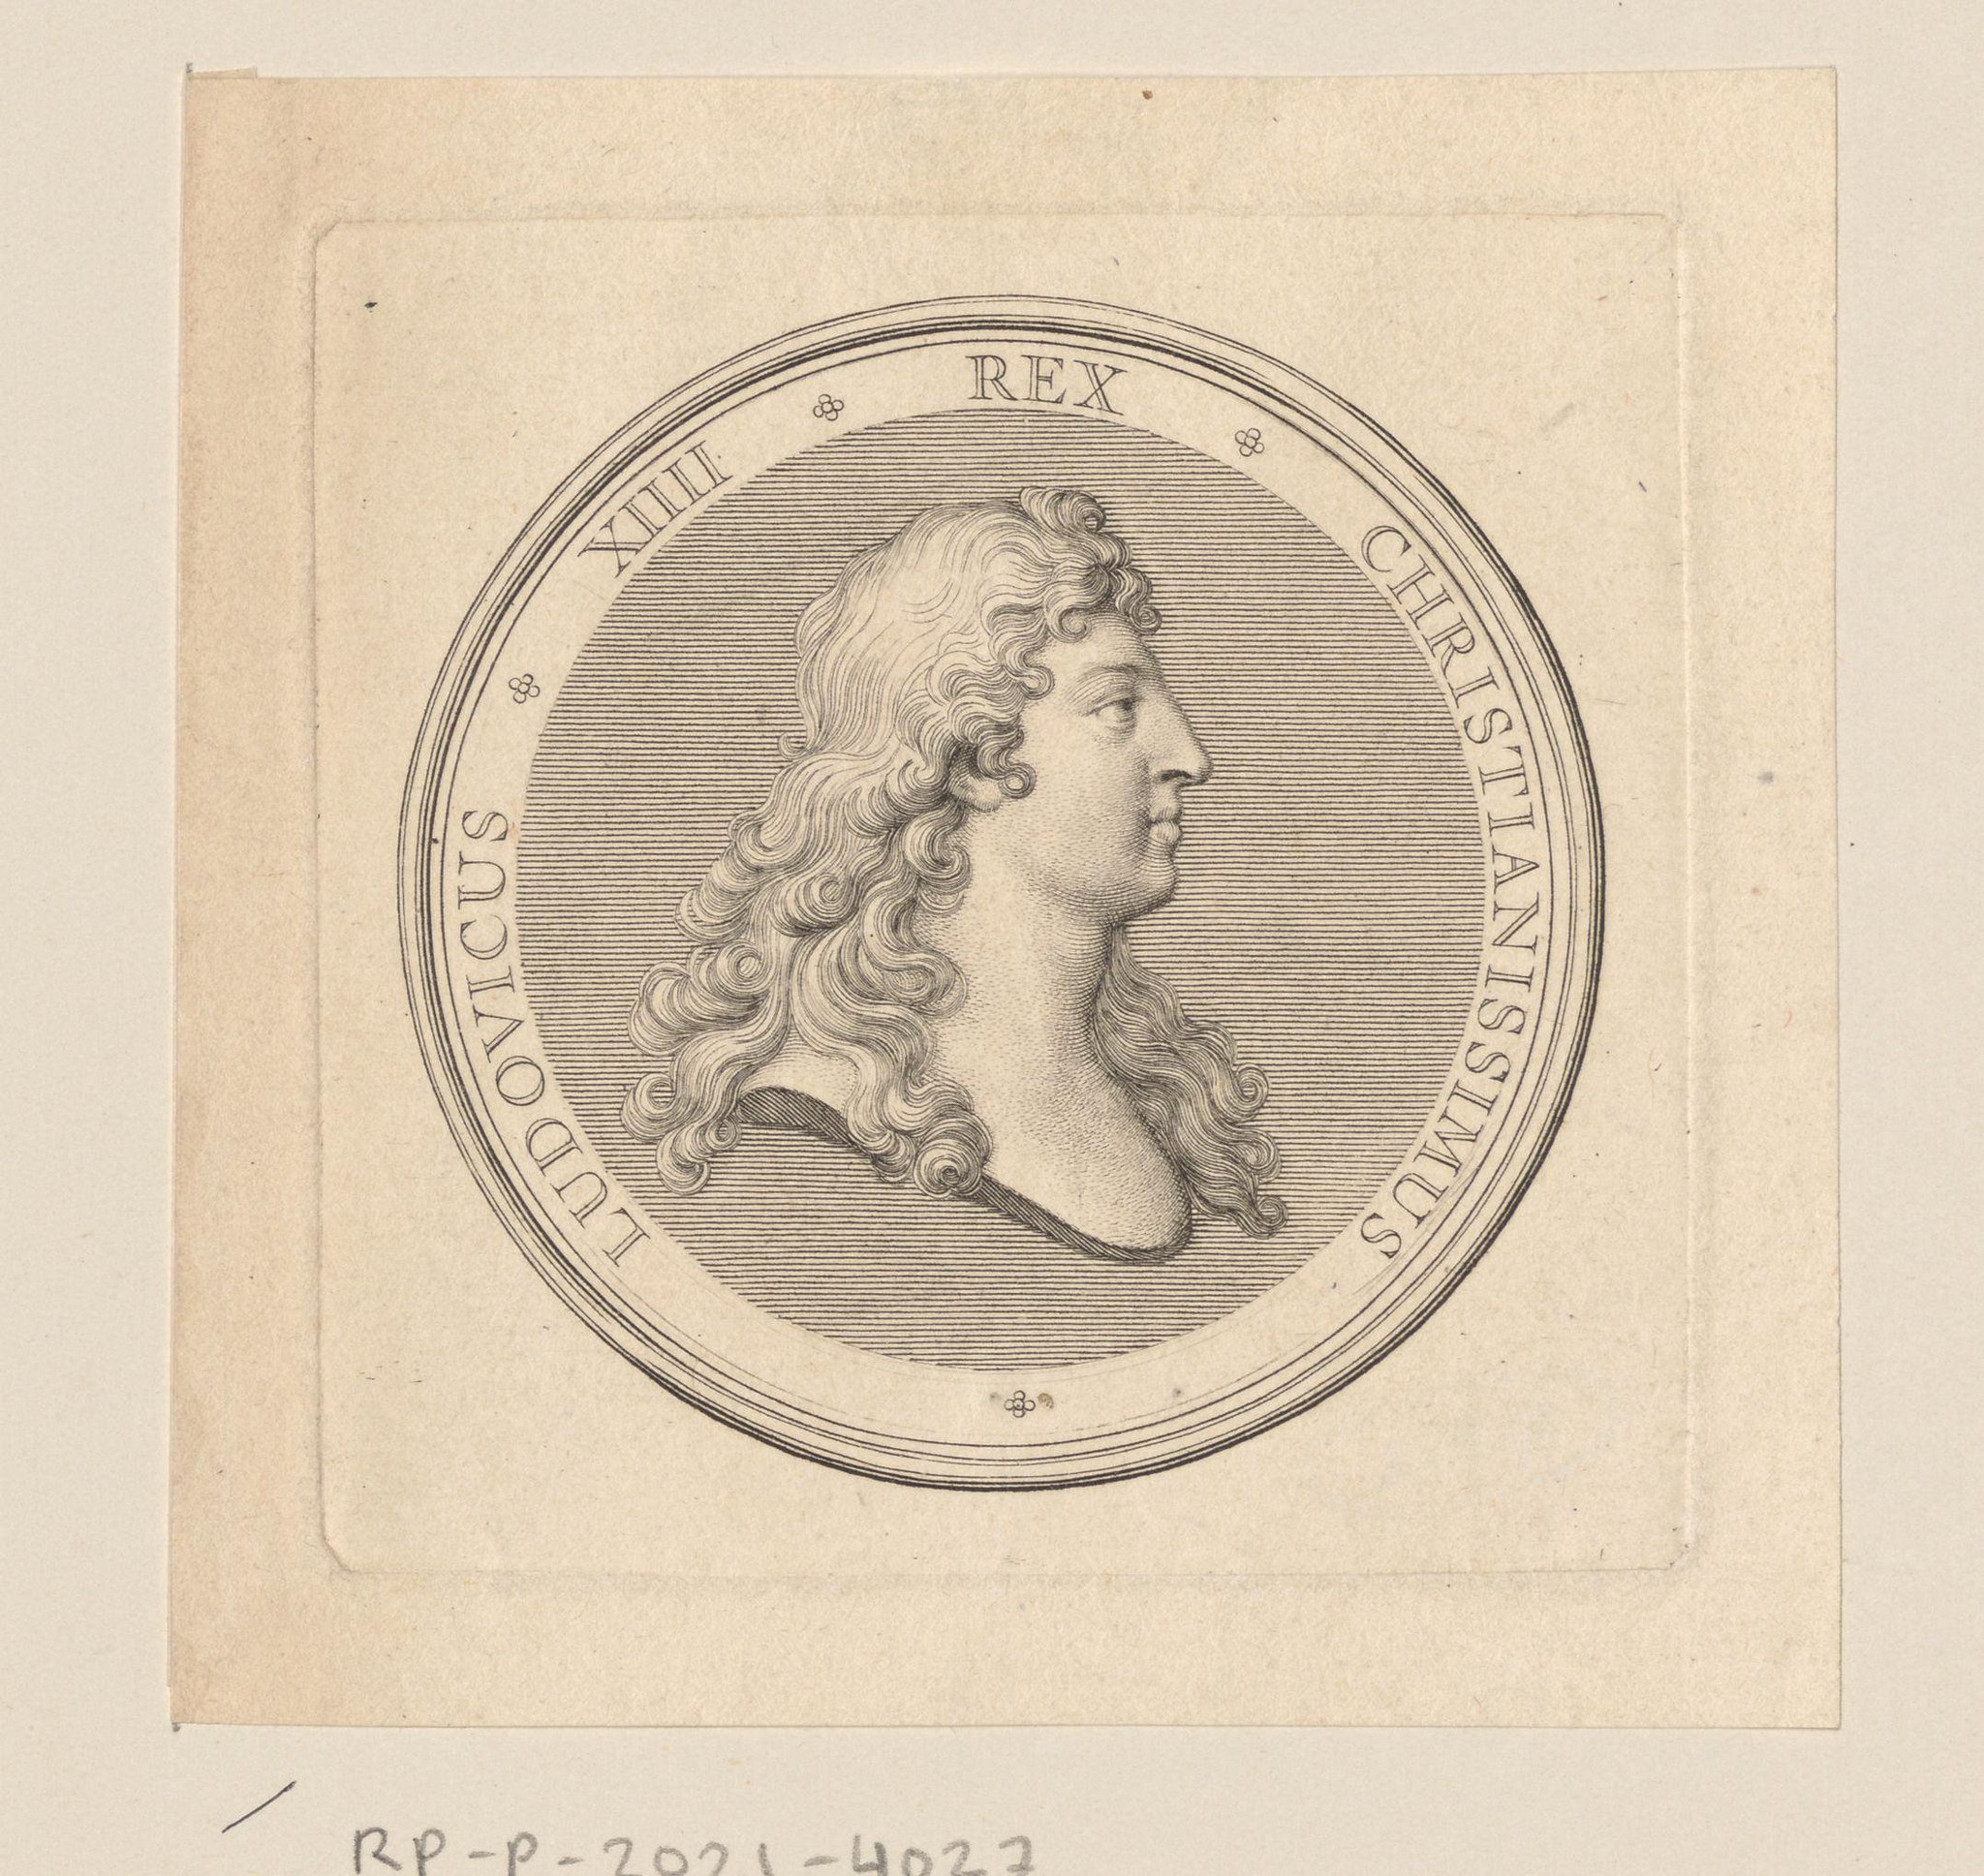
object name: print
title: Penning met buste van Lodewijk XIV van Frankrijk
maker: Anonymous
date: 1723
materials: paper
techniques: engraving, etching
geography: paris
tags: lodewijk xiv (koning van frankrijk), historical persons, medal (considered as a piece of sculpture, regardless of its specific function), king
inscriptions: collector's mark: Lugt 2228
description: Prent waarschijnlijk uit: Medailles sur les principaux evenements de regne de Louis le Grand (...). Parijs: L'Imprimerie Royale, 1723.